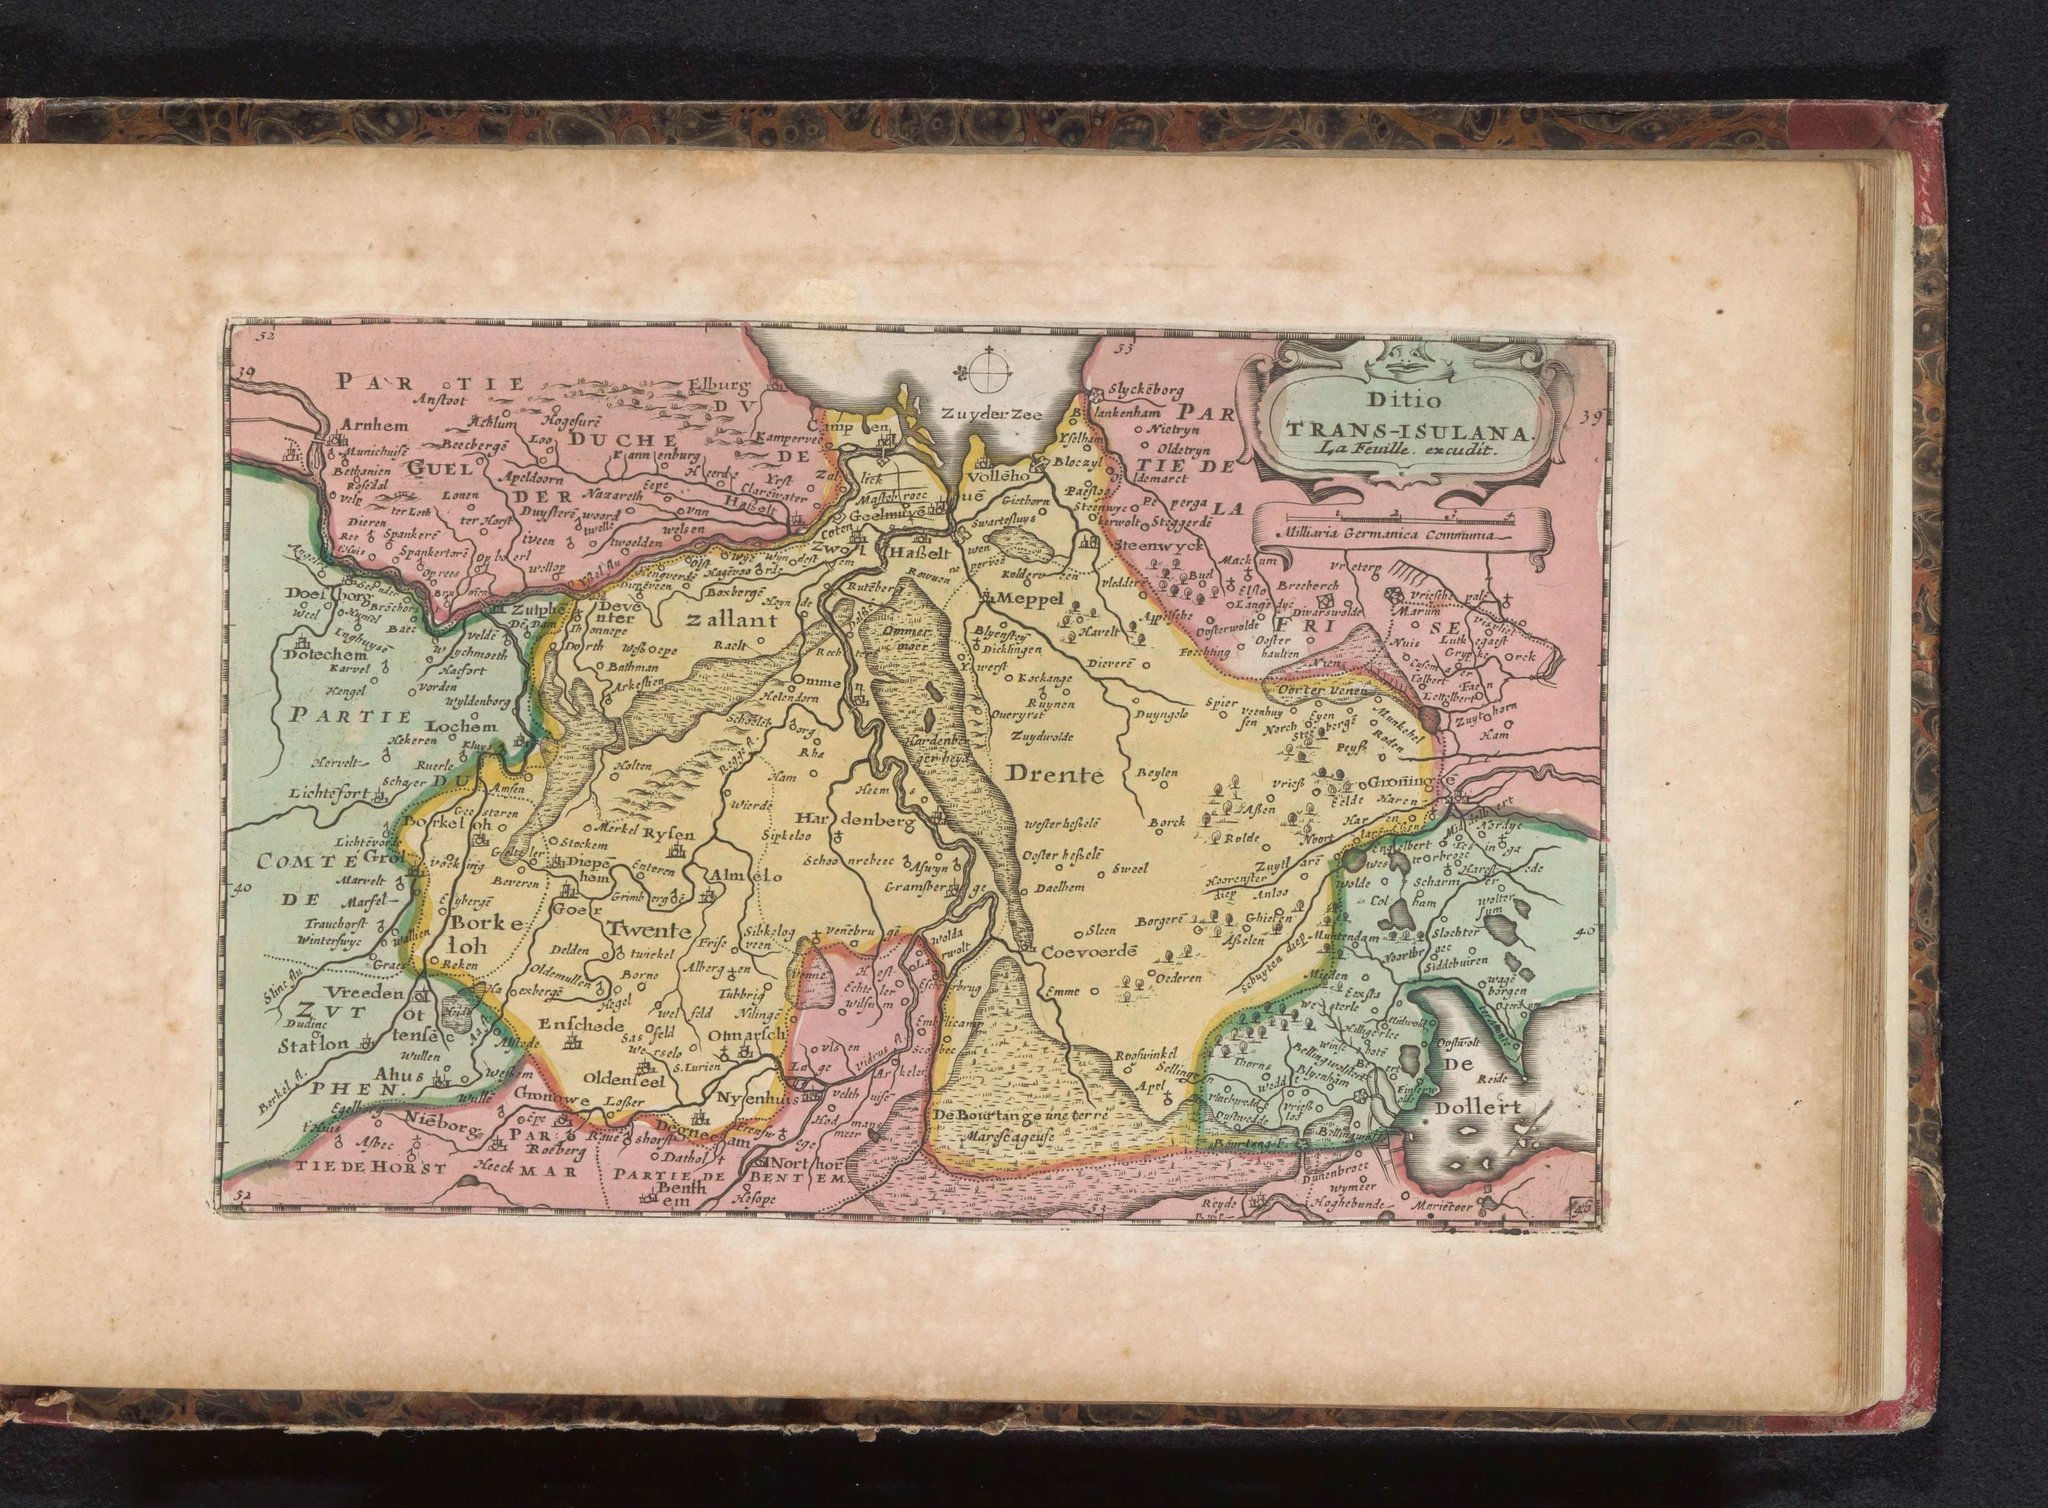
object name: print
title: Ditio Trans-Isulana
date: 1700-1702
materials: paper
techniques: engraving, hand coloring, lacquer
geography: amsterdam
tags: maps of separate countries or regions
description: Kaart van Overijssel, Drenthe en Twente. Onderdeel van een atlas met 223 kaarten van landen en steden en oorlogstaferelen in Europa in de periode ca. 1690-1735.